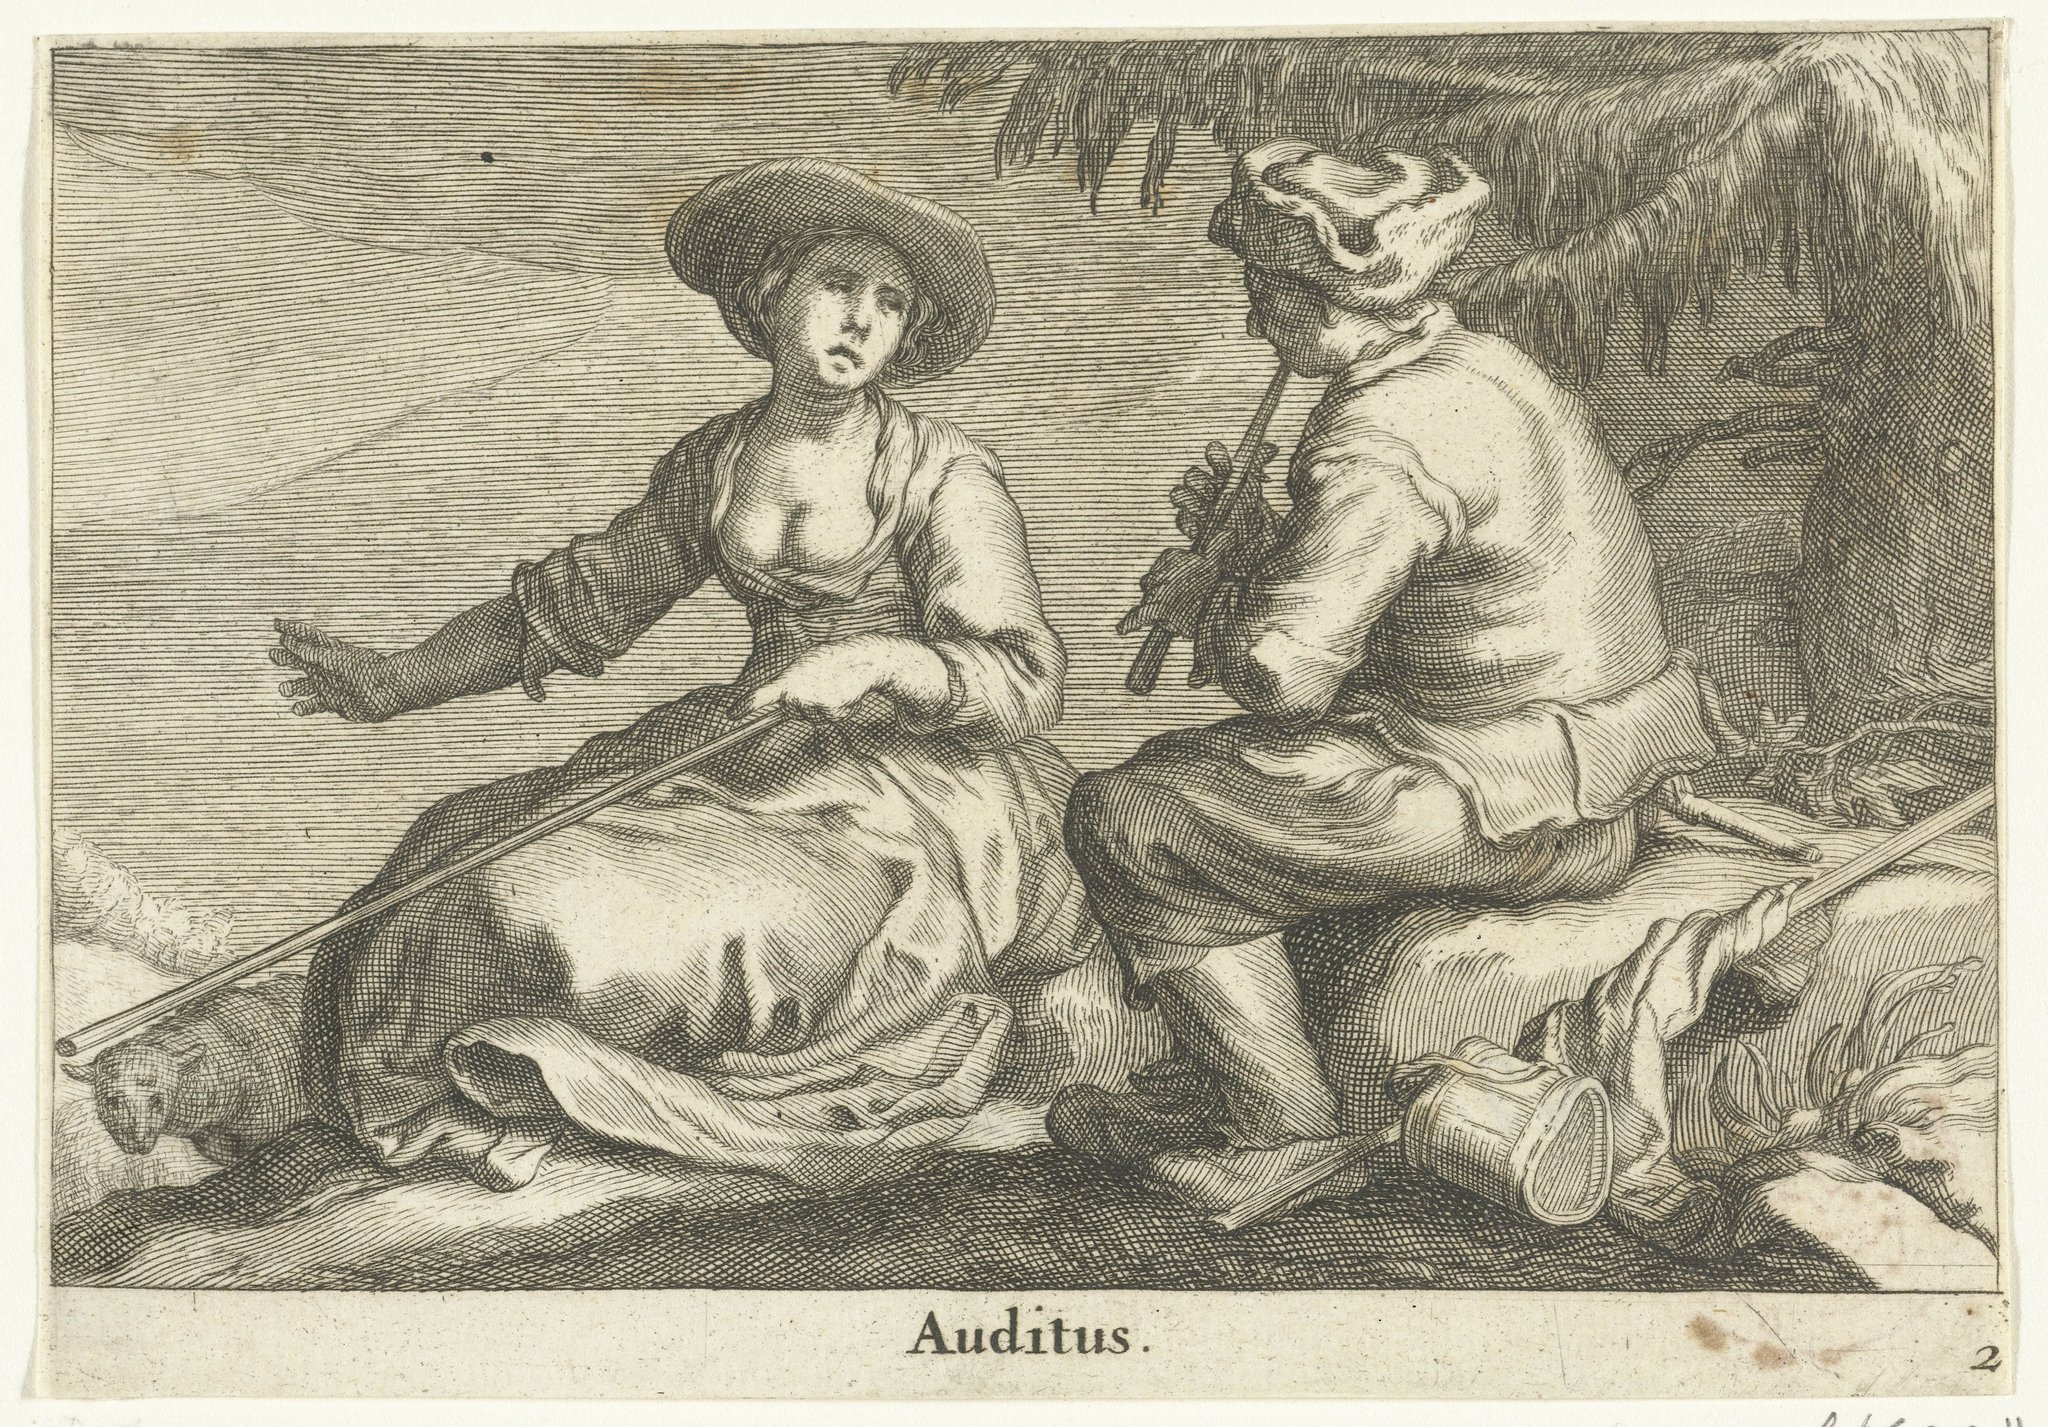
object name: print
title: Gehoor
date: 1632-1670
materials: paper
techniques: engraving, etching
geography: amsterdam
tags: transverse flute - cc - out of doors, hearing, listening (one of the five senses), herding, herdsman, herdswoman, shepherd, shepherdess, cowherd, etc.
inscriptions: collector's mark: Lugt 240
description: Onder een boom speelt een man fluit voor een herderin. Voorstelling van het Gehoor, uit een serie met vijf prenten die de zintuigen afbeelden.